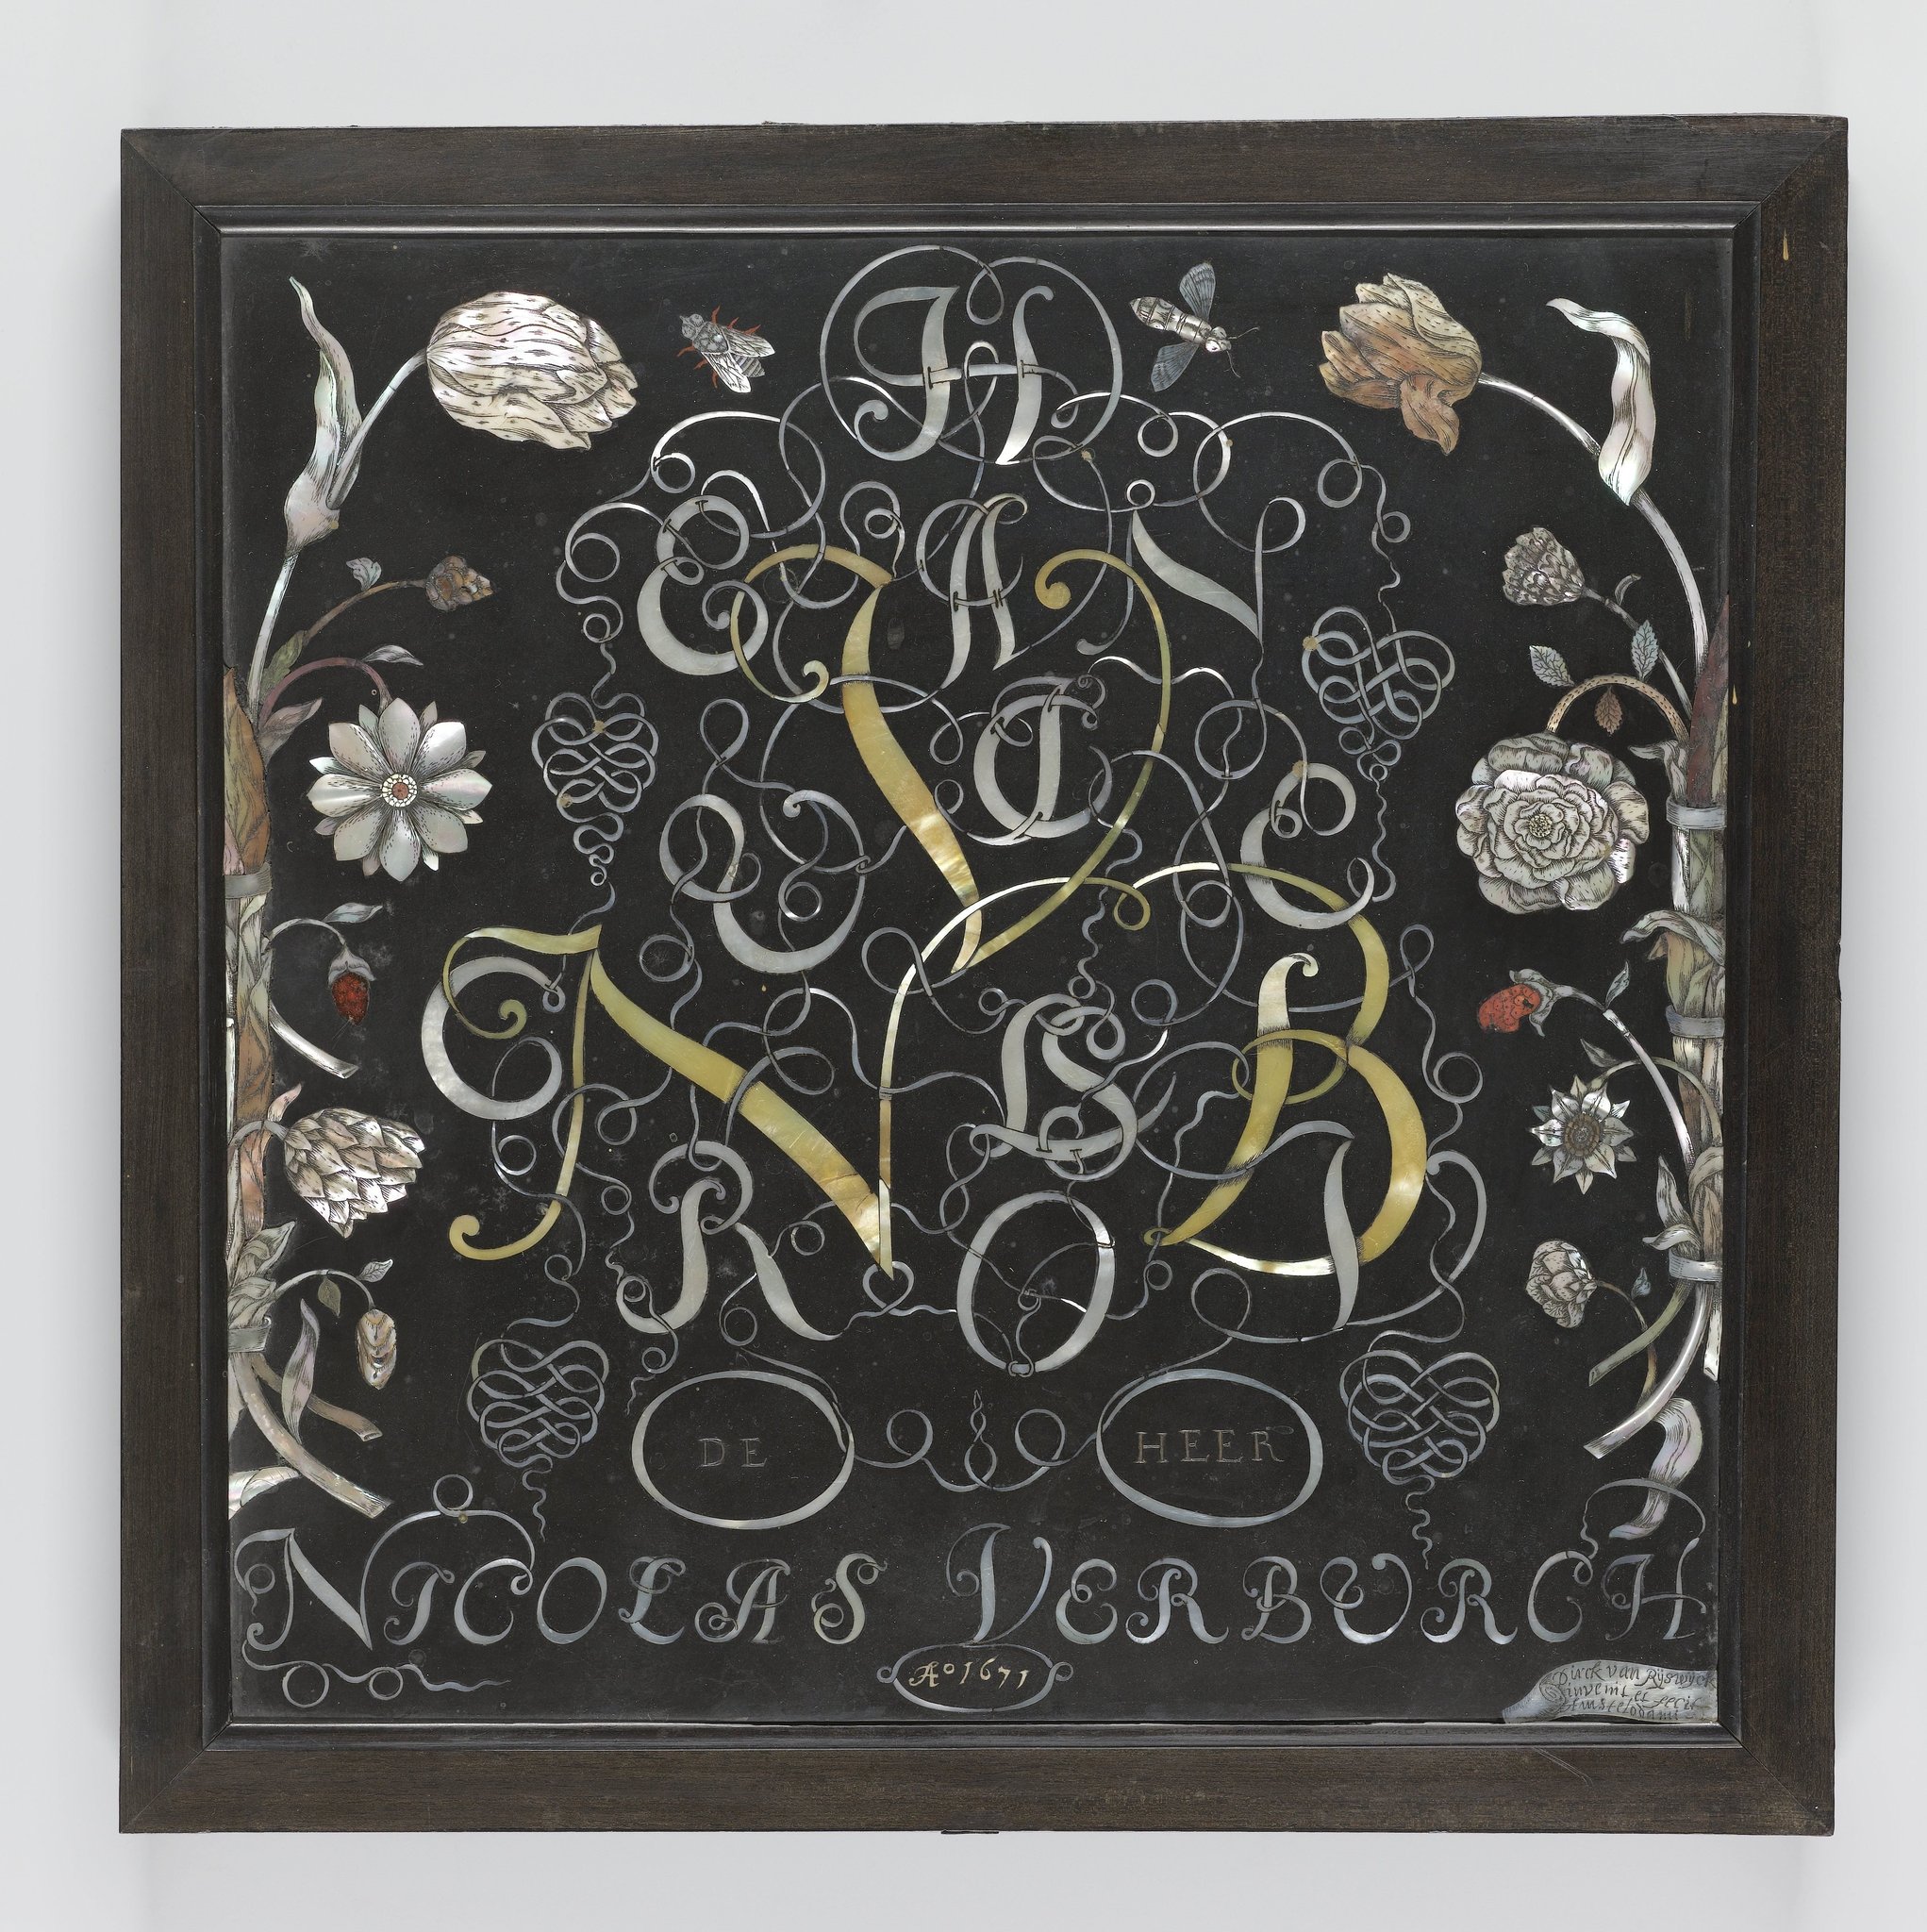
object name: panel ornament area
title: Panel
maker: dirk van rijswijck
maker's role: medailleur, paarlemoerinlegger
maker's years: 1596-1679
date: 1671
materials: marble, mother of pearl, stone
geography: amsterdam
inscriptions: date: ‘Ao 1671’, signature: ‘Dirck van Rijswijck // invenit et fecit // Amstelodami’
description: Lydian stone, inlaid with mother-of-pearl and marble The calligraphic composition is composed of letter from the name Nicolas Verburch, which is repeated at the bottom of the panel. Verburch was a high-ranking functionary of the Dutch East India Company.